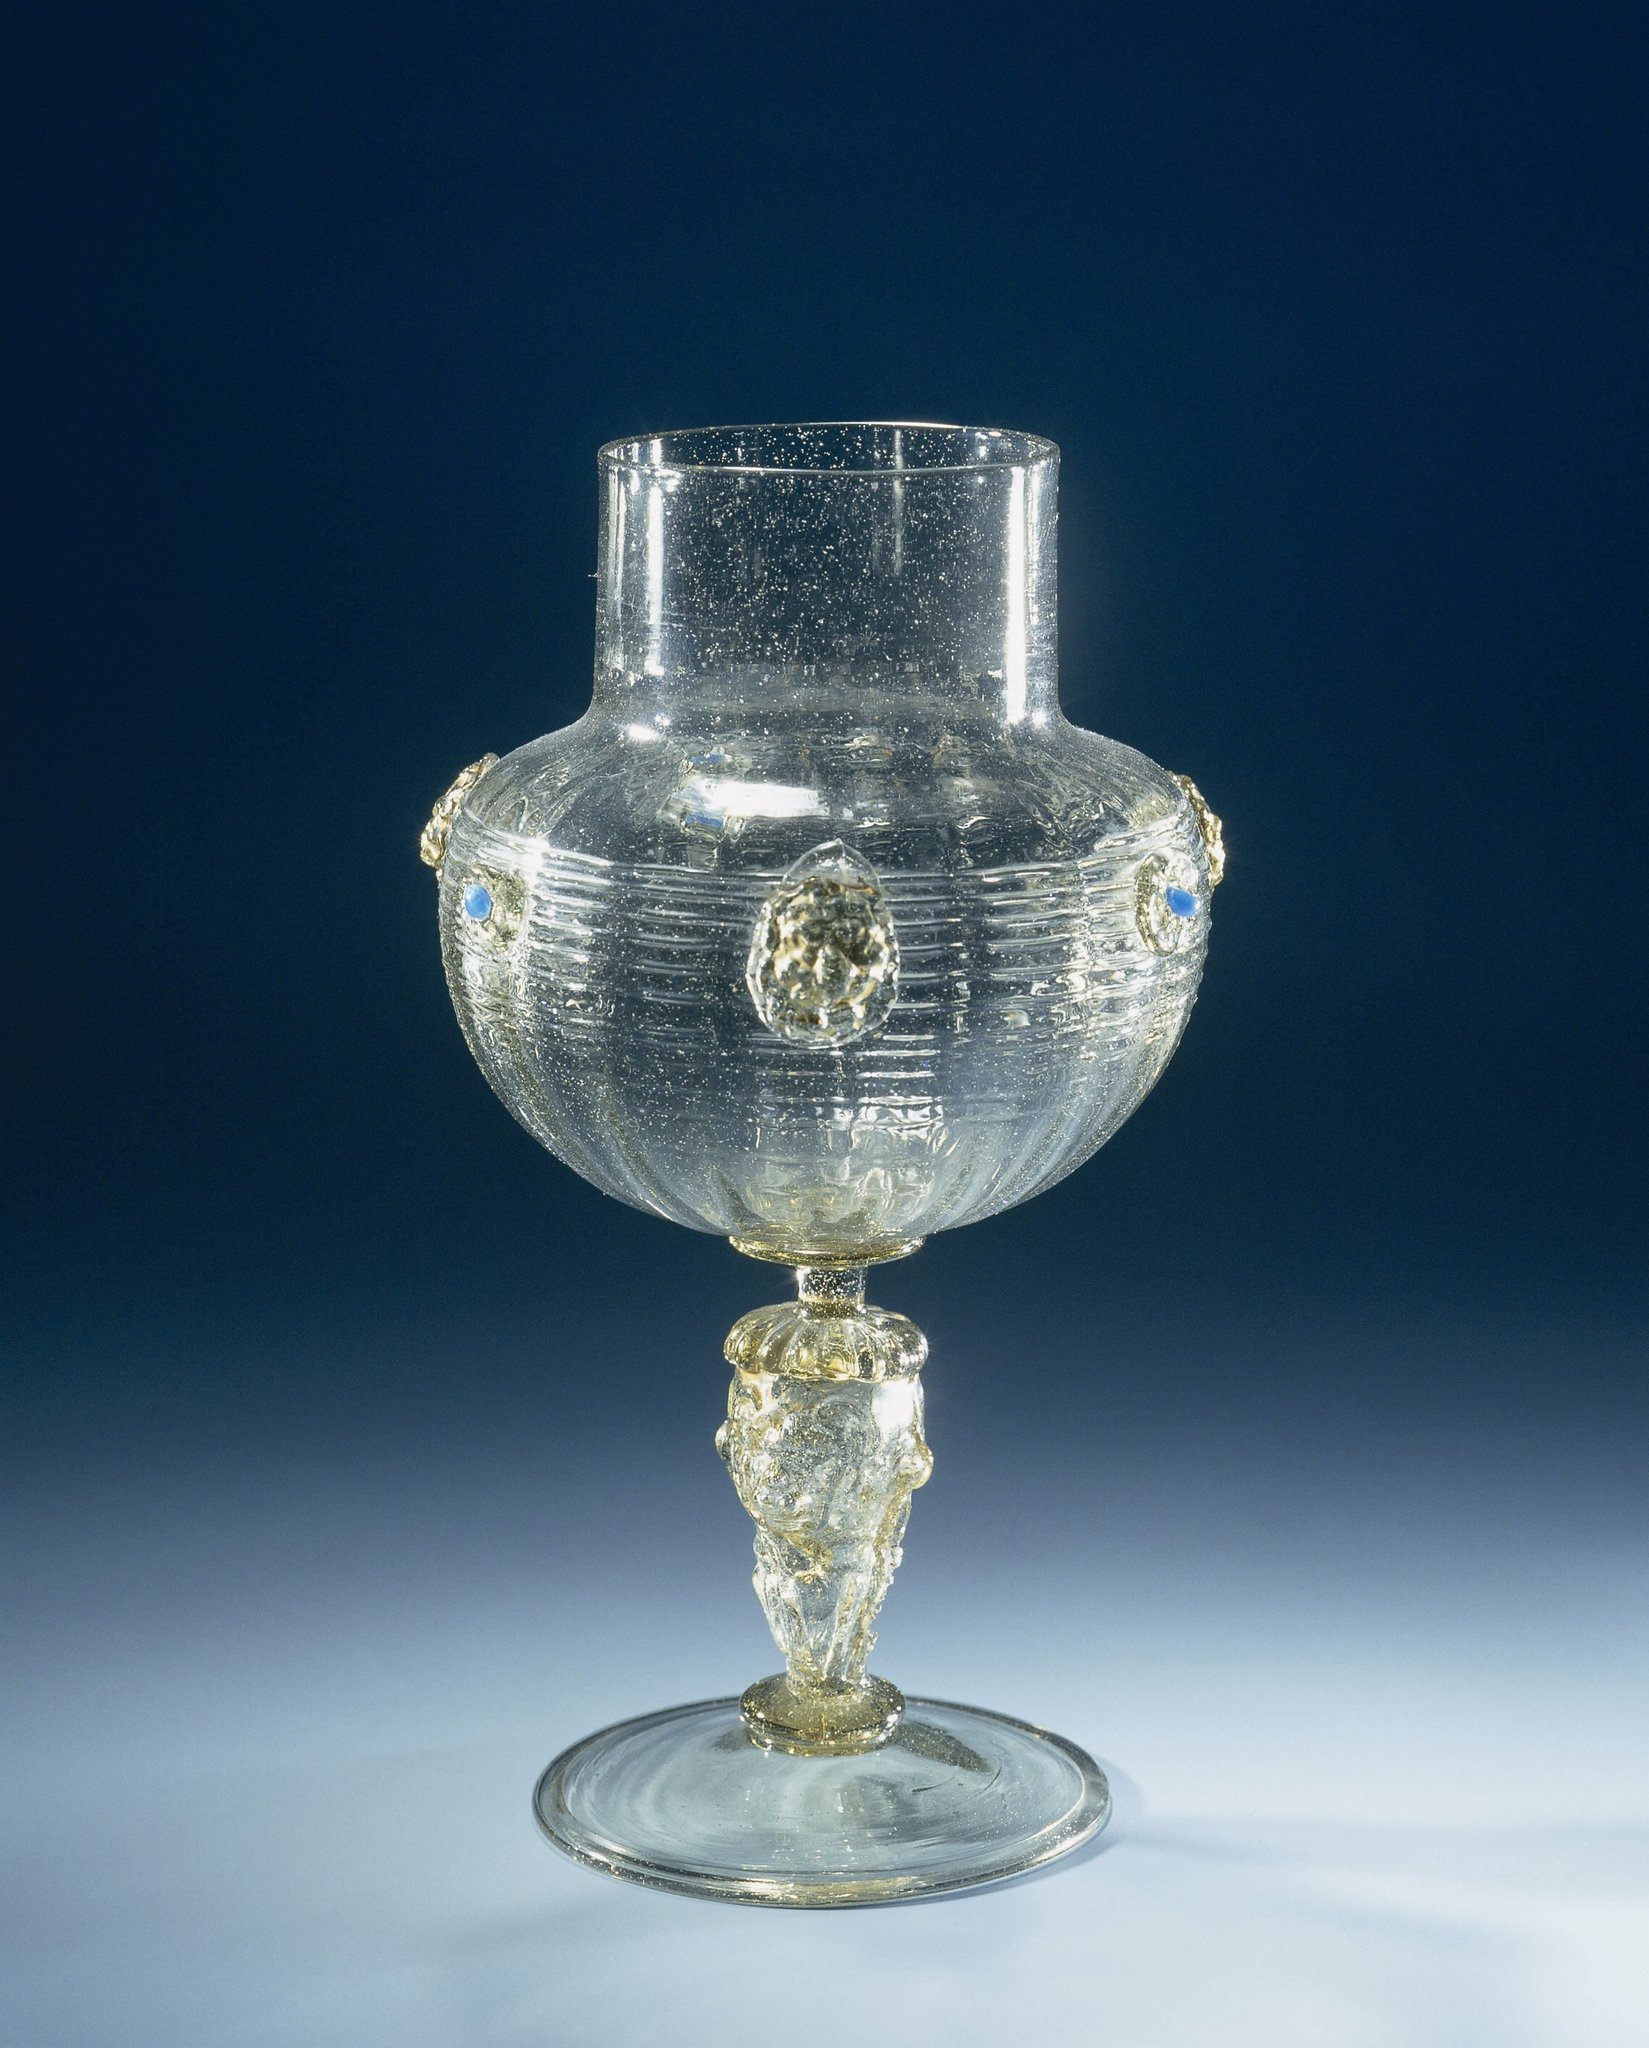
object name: goblet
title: Bokaal met mascarons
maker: Anonymous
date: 1550-1600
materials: glass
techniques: façon de venise, gilding, glassblowing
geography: low countries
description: Goblet. Netherlands, façon de Venise, c. 1550-1600.